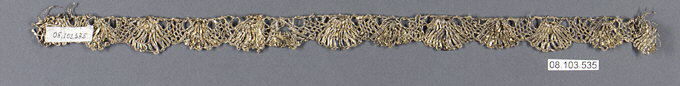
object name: piece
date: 1701-1800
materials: gold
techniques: lace